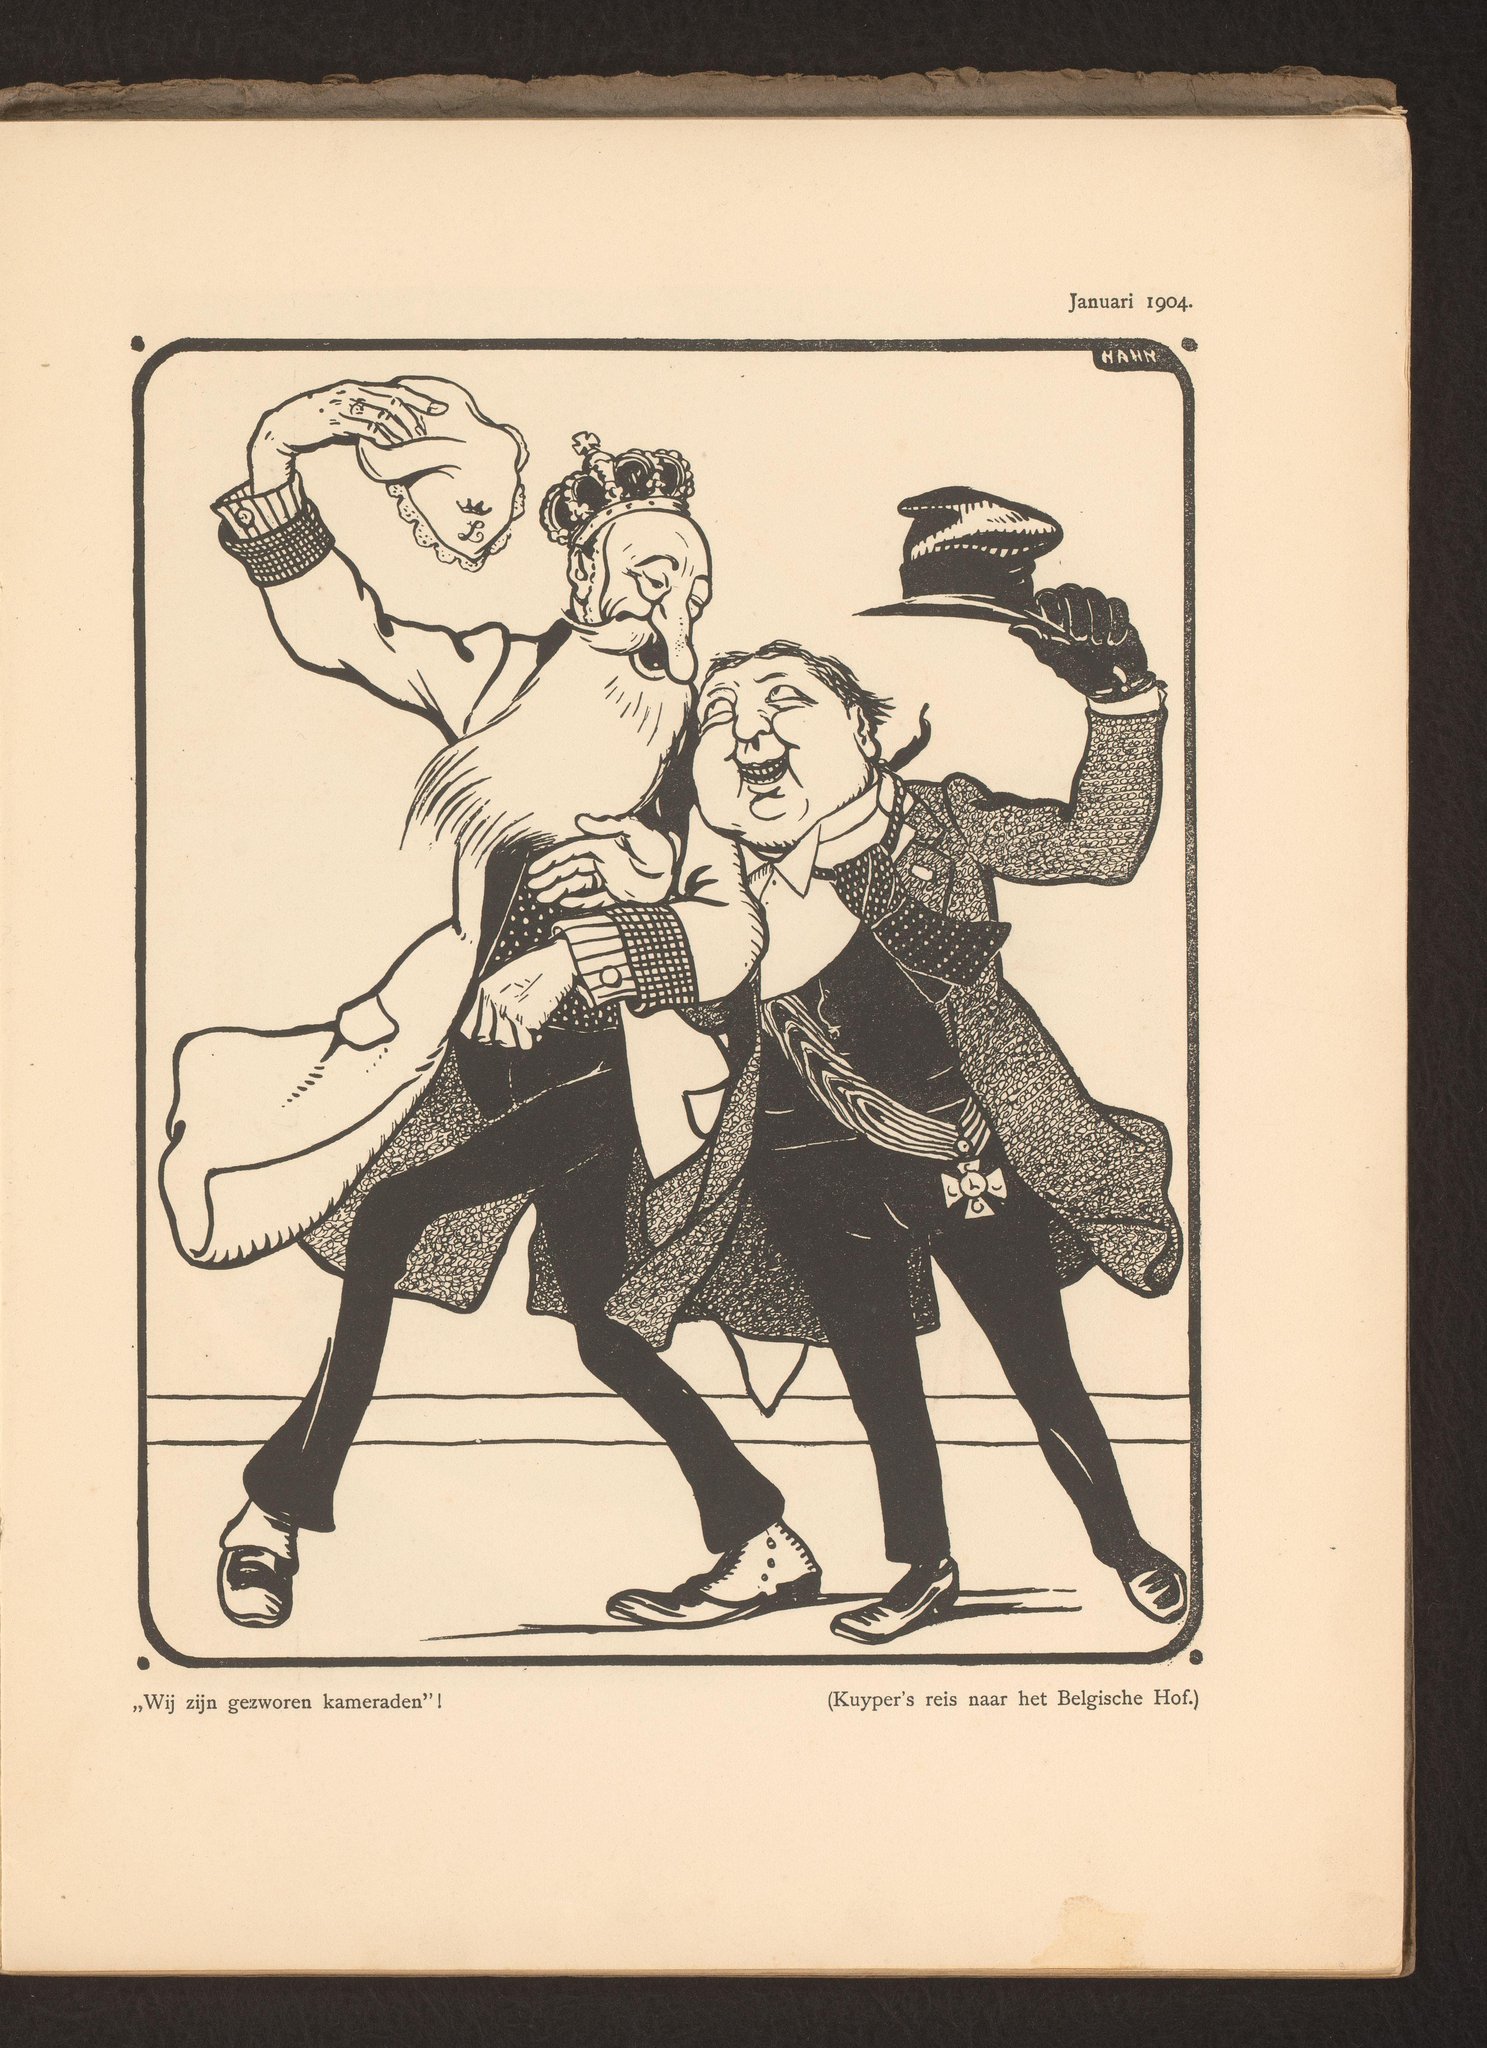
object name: photomechanical print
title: "Wij zijn gezworen kameraden"!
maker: albert hahn (i)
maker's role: draughtsman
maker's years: 1877-1918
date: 1901-1904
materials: paper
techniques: autotype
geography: netherlands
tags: laeken, leopold ii (koning der belgen), the hague, abraham kuyper, friends, political caricatures and satires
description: Abraham Kuyper vrolijk gearmd met de Belgische koning Leopold II, januari 1904. Onderdeel van het boek 'Albert Hahn Prenten', heruitgave van een selectie politieke prenten uit de periode 1902-1906.